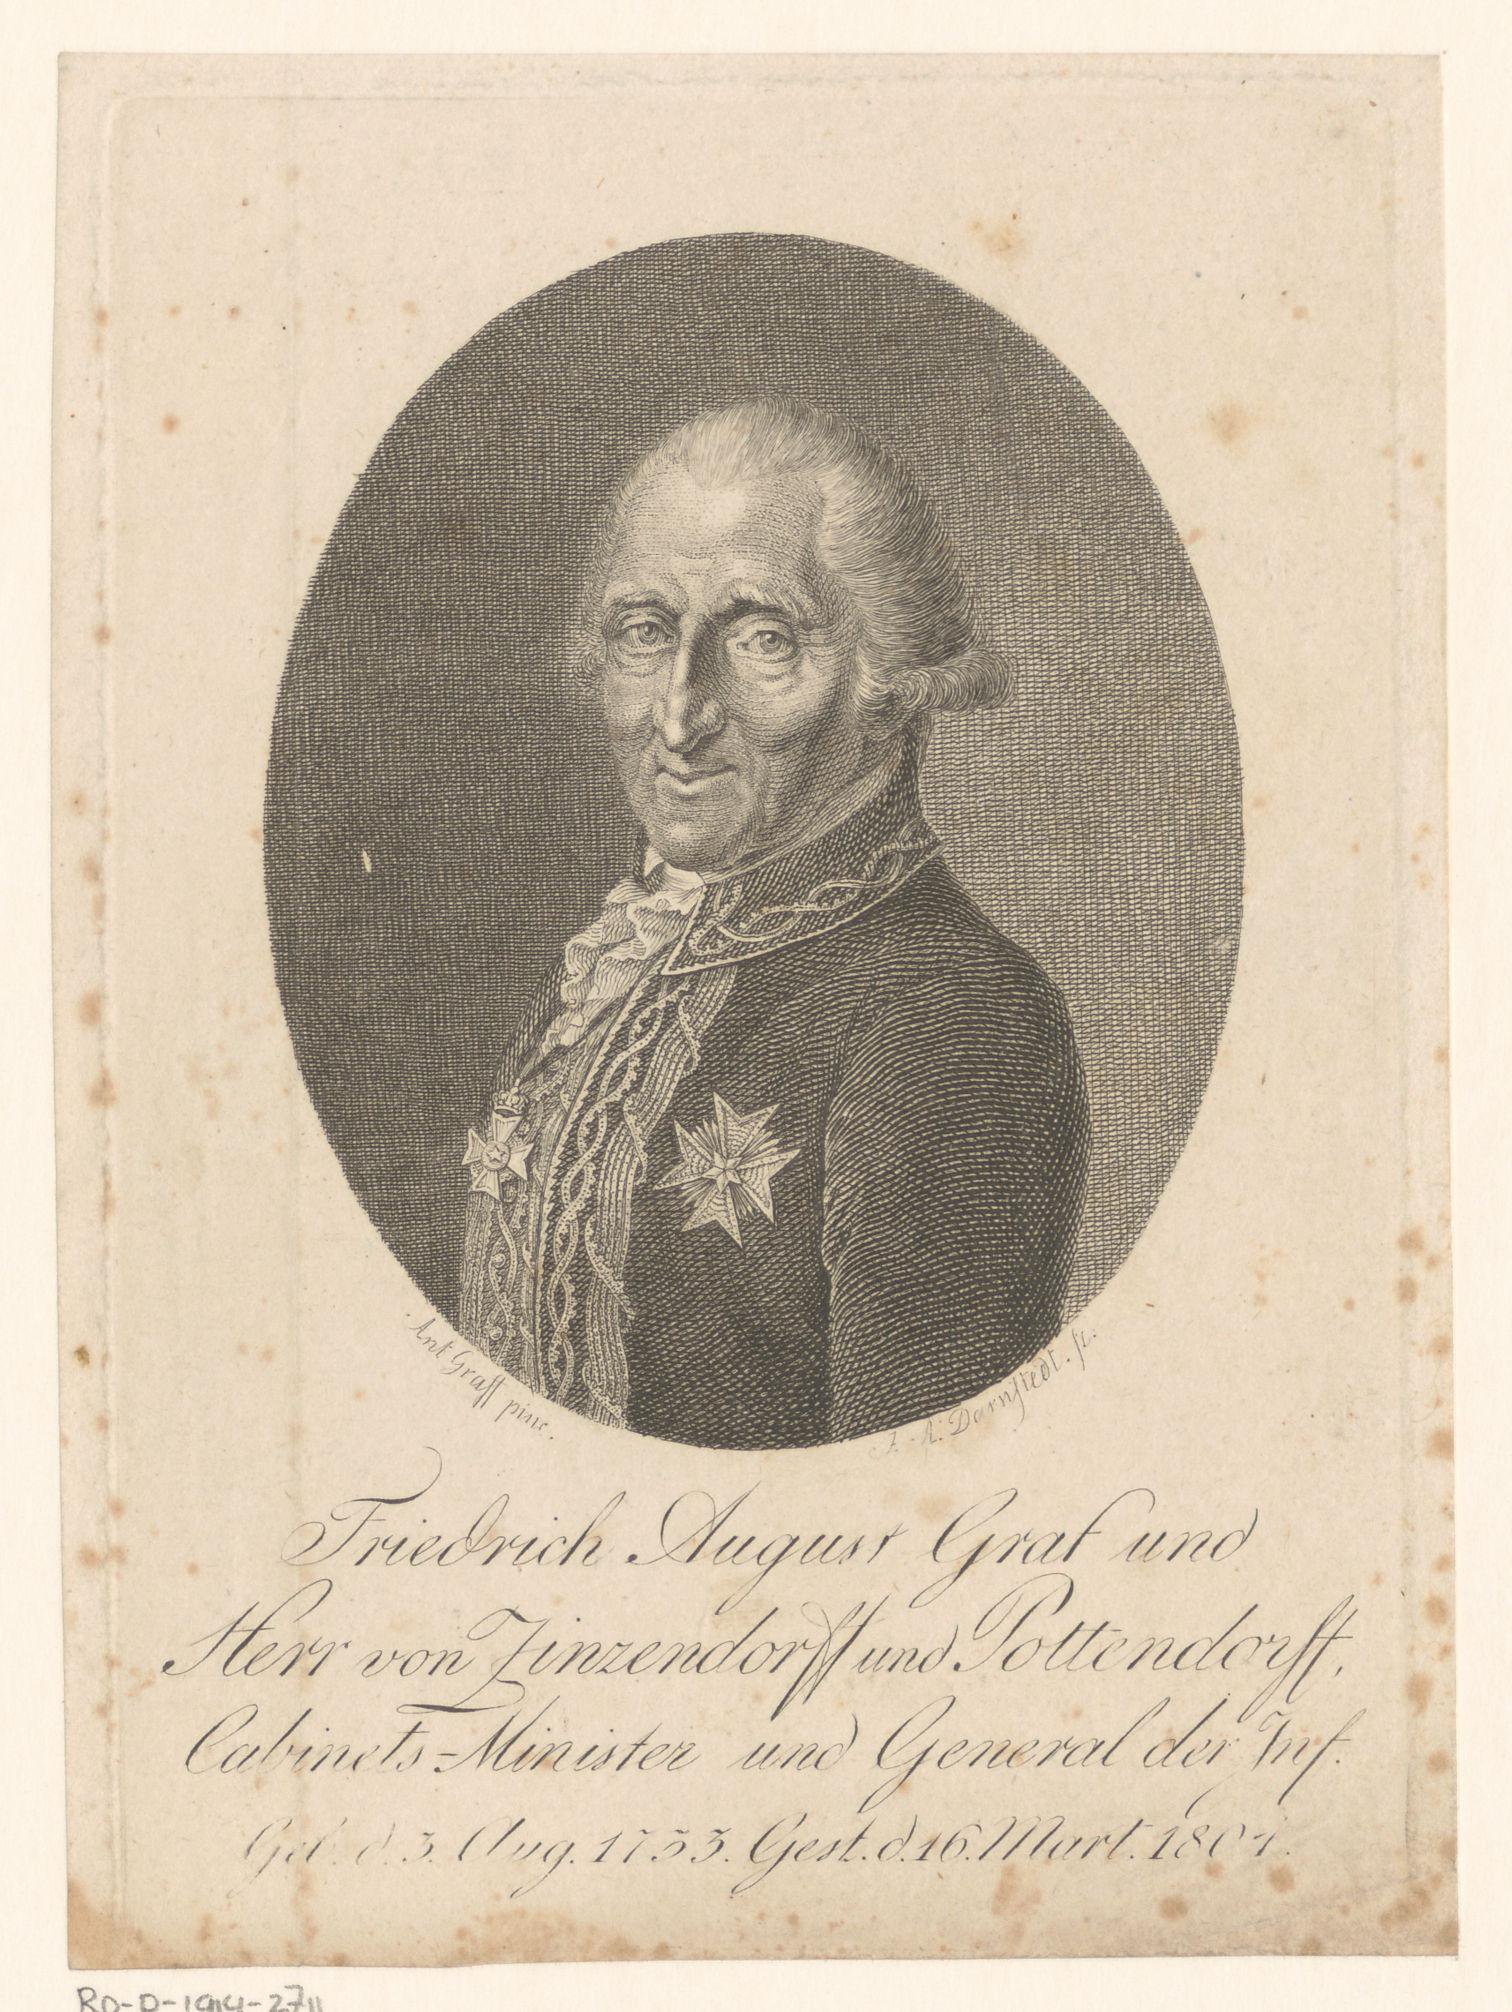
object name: print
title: Portret van Friedrich August Graf von Zinzendorf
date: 1804-1844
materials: paper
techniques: engraving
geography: dresden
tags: politician, knighthood order, historical persons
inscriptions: collector's mark: Lugt 2228